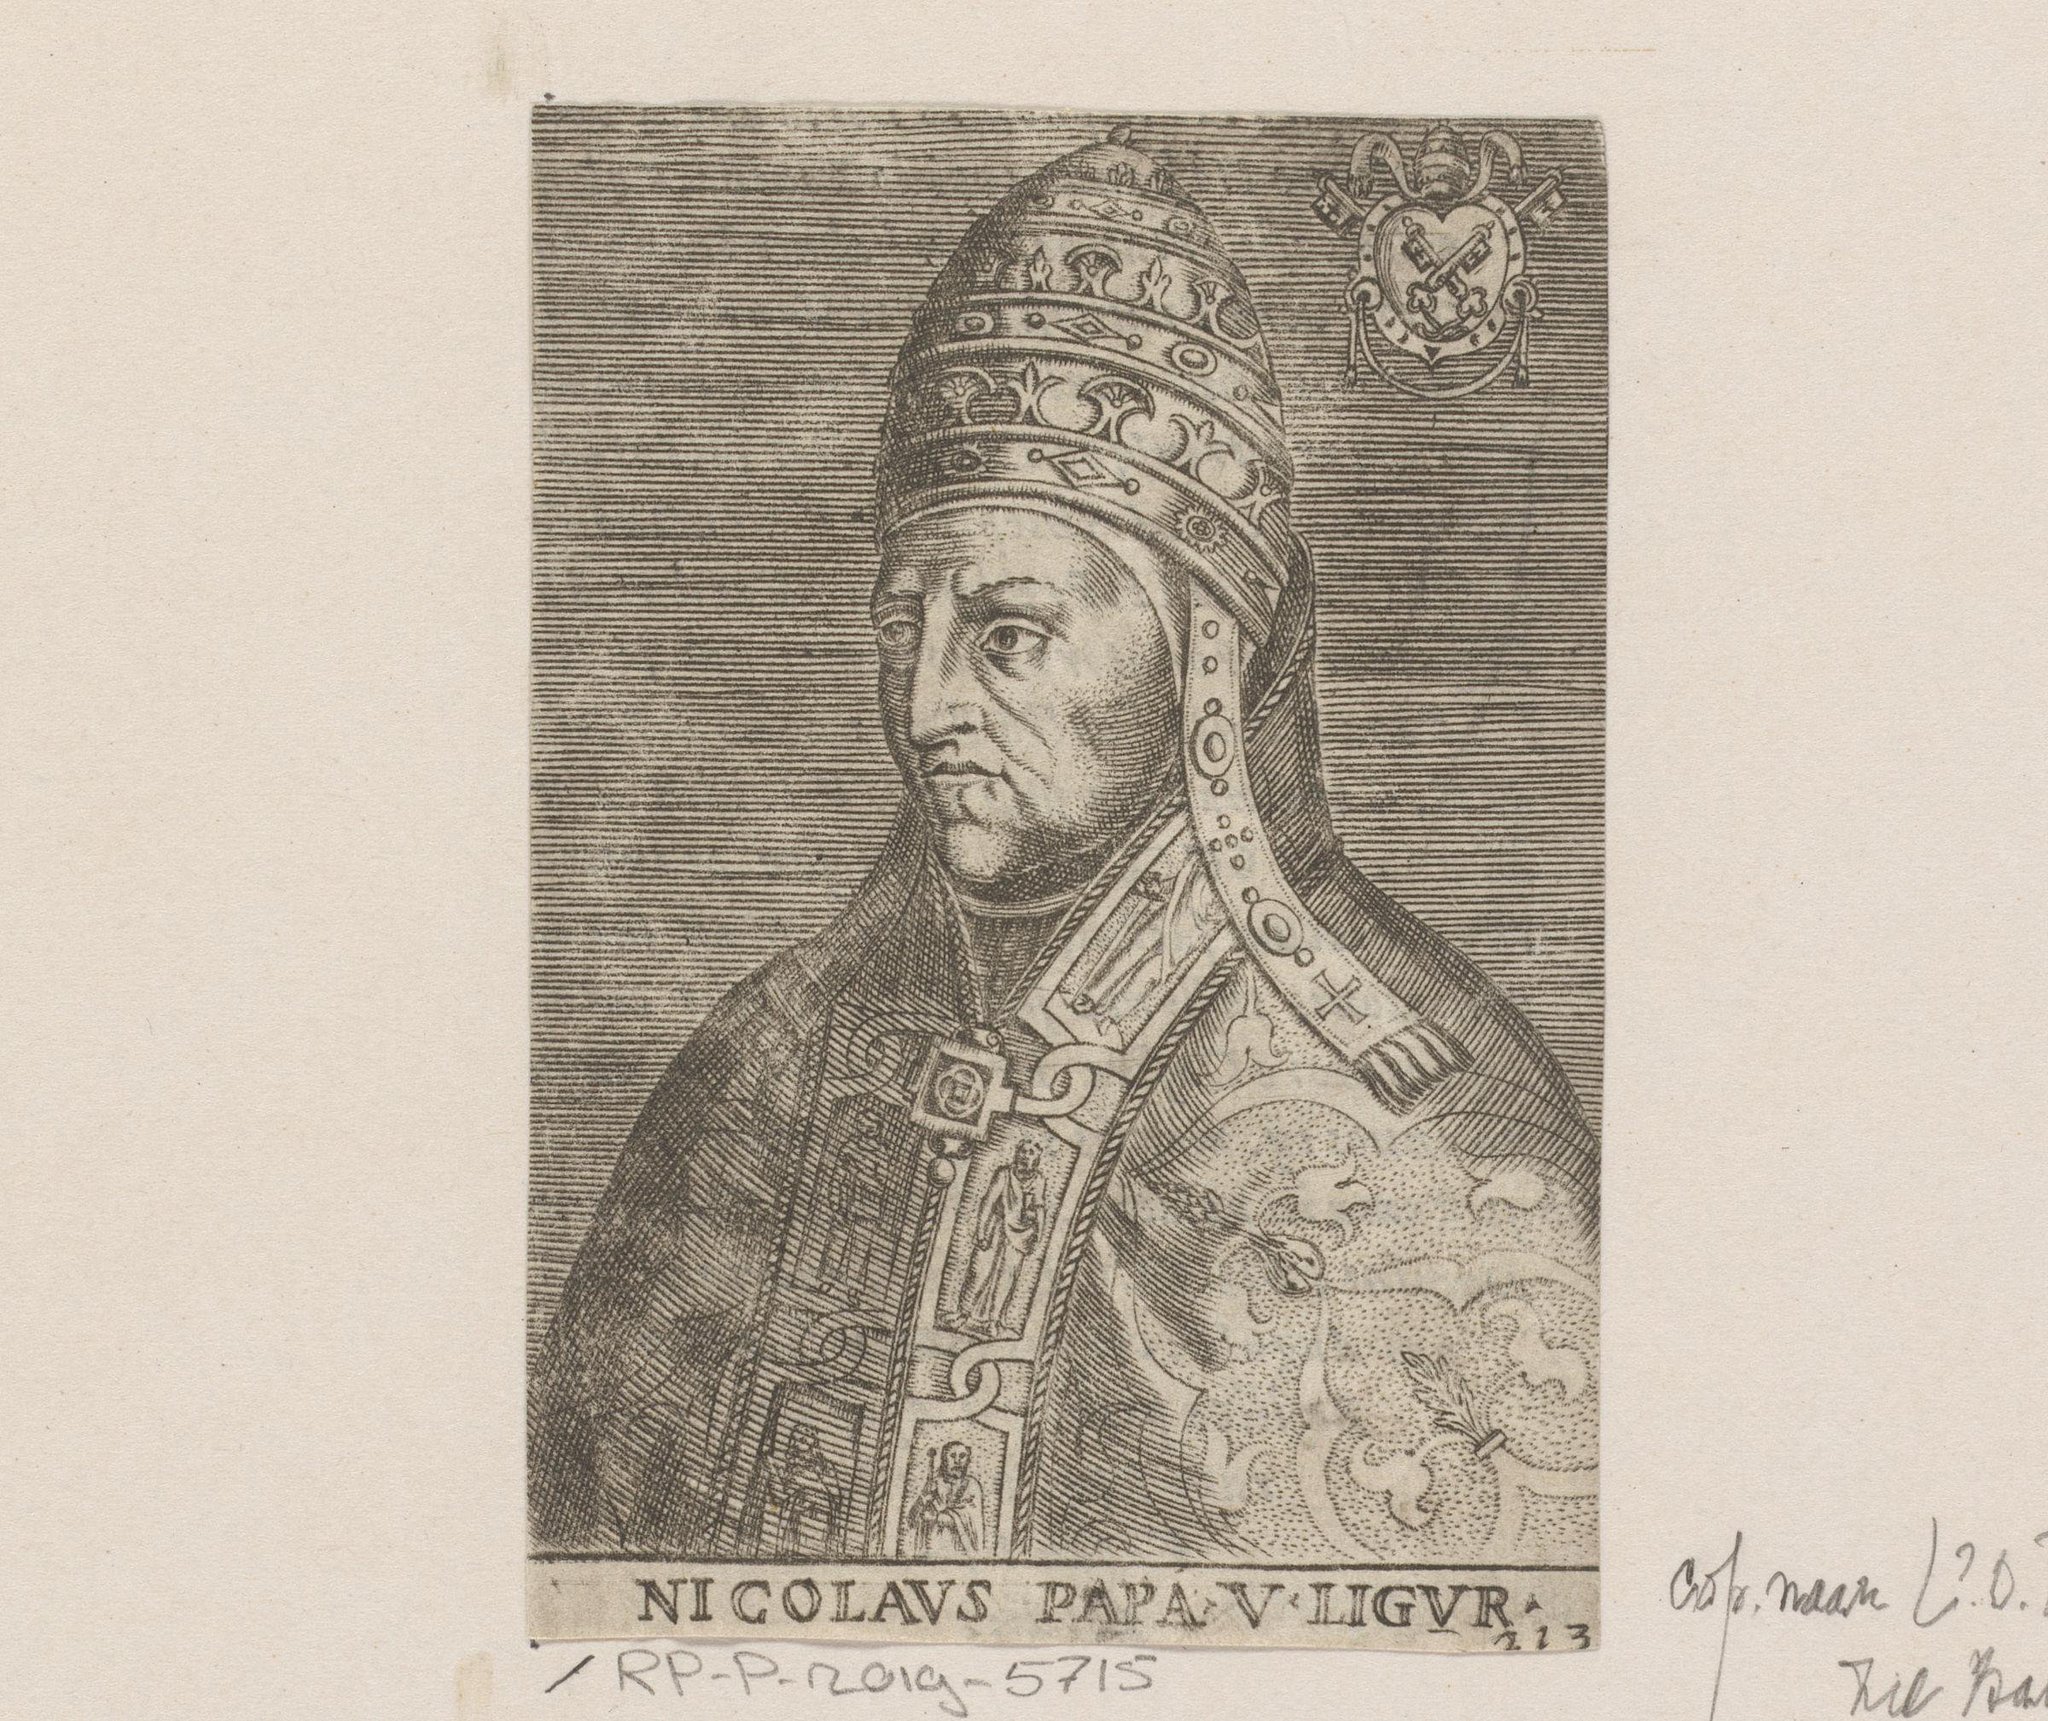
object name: print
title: Nicolaus Papa V Ligur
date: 1624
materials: paper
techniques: engraving, letterpress printing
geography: rome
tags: rome, historical persons, pope, armorial bearing, heraldry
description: Prent uit: Tempesta, Domenico. Vite et effigie di tutti li pontefici romani (...). Rome: Giacomo Crulli de Marcucci, 1624. Prent voor het eerst verschenen in: Cavalieri, Giovanni Battista de'. Pontificum romanorum effigies (...). Rome: Domenico Basa en Francesco Zanetti, 1580. Prent ook gebruikt in latere publicaties.